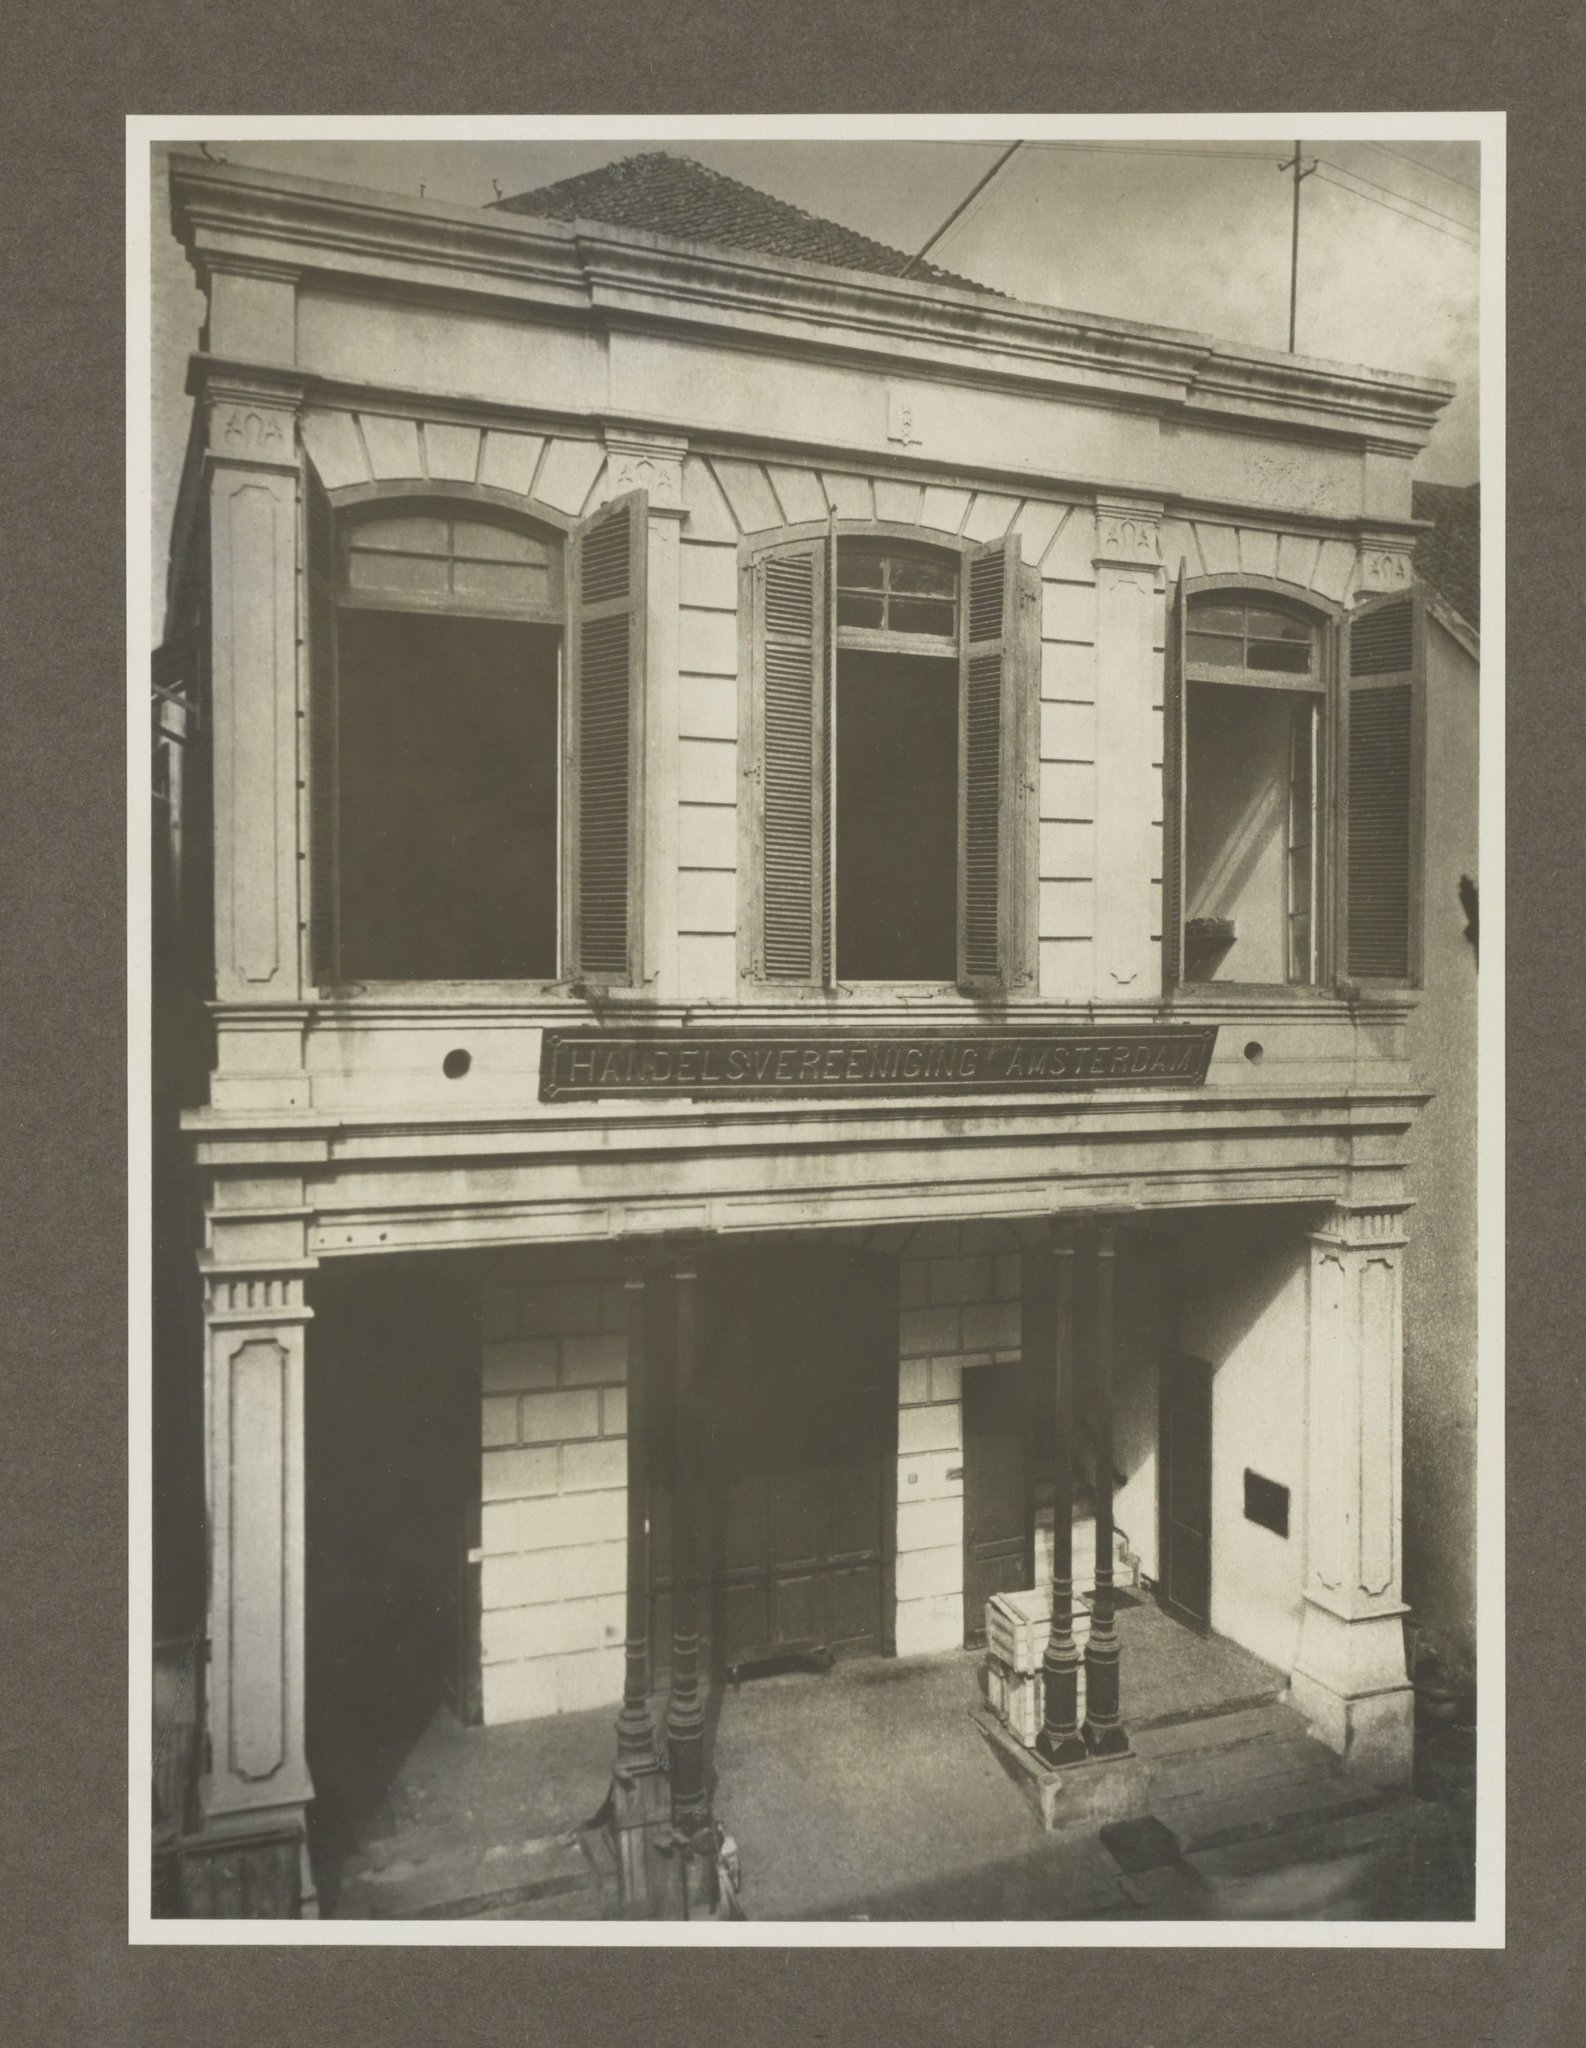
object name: photograph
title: 1910-1922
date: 1904-1931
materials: photographic support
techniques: gelatin silver print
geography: surabaya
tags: colonial system, trade-company, representation of real building (either existing or having existed), surabaya, java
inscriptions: inscription: ‘1910-1922.’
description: Gevel van het kantoor van de HVA te Soerabaja in de periode 1910-1922. Foto in het het fotoalbum aangeboden aan A. van der Eyk namens de chefs en het personeel van de Handelsvereniging Amsterdam (HVA) te Soerabaja bij zijn vertrek van Java in april 1931.